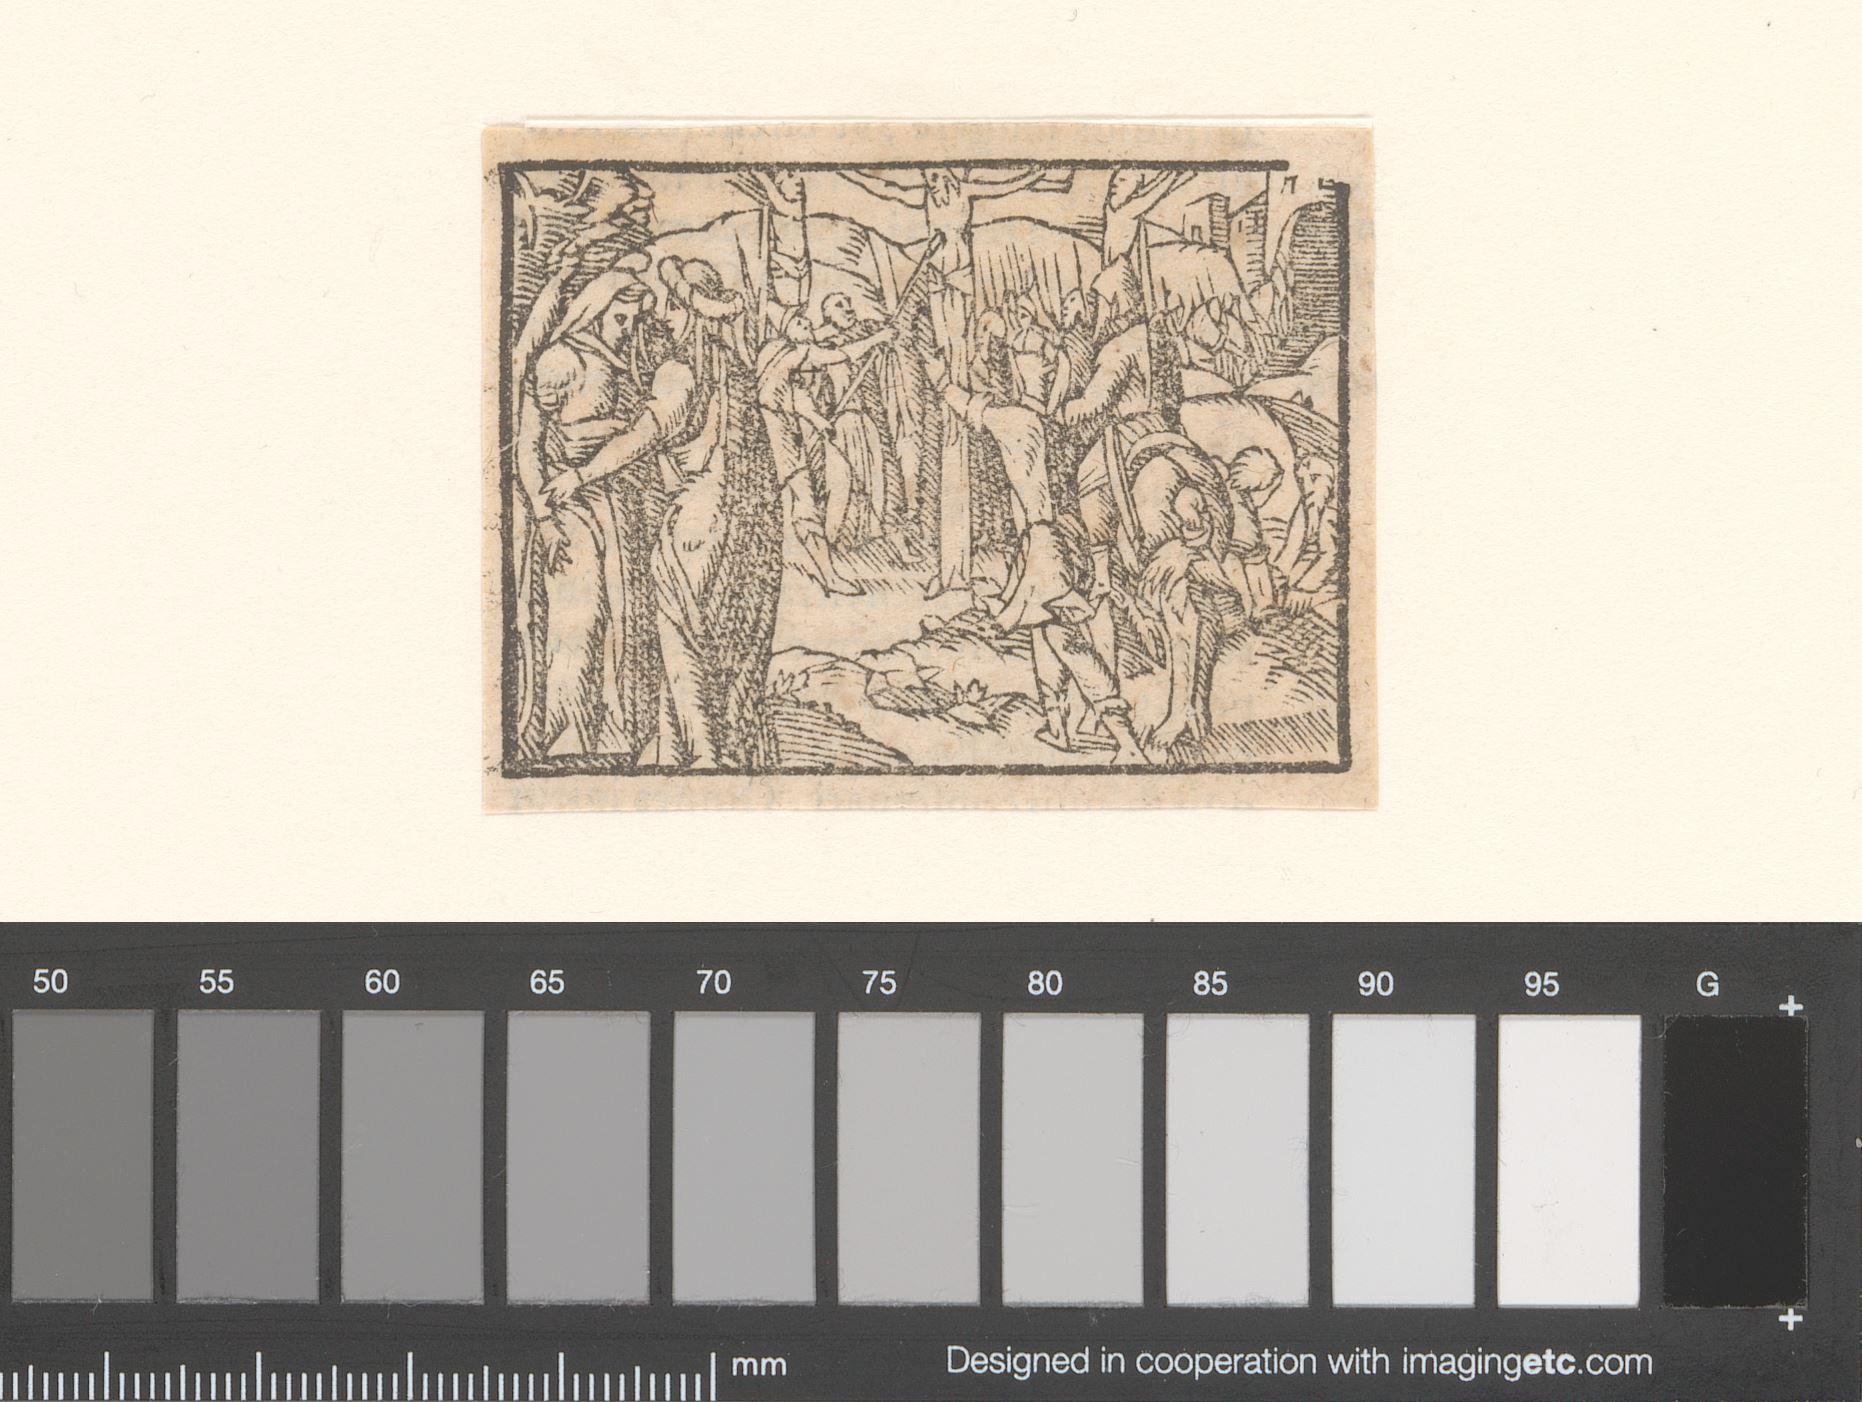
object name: print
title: Christus aan het kruis met Longinus die hem in zijn zij steekt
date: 1591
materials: paper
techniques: letterpress printing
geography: germany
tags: crucified christ, with particular persons under the cross, longinus pierces christ's side with a lance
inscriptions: collector's mark: Lugt 2228, collector's mark: Lugt 2760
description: Prent uit: Granada, Luis de. Vita Christi (...). Keulen: Gerwen Calenius en erven Johann Quentel, 1591, p. 587. Prent ook gebruikt in eerdere editie van het werk uit 1586.